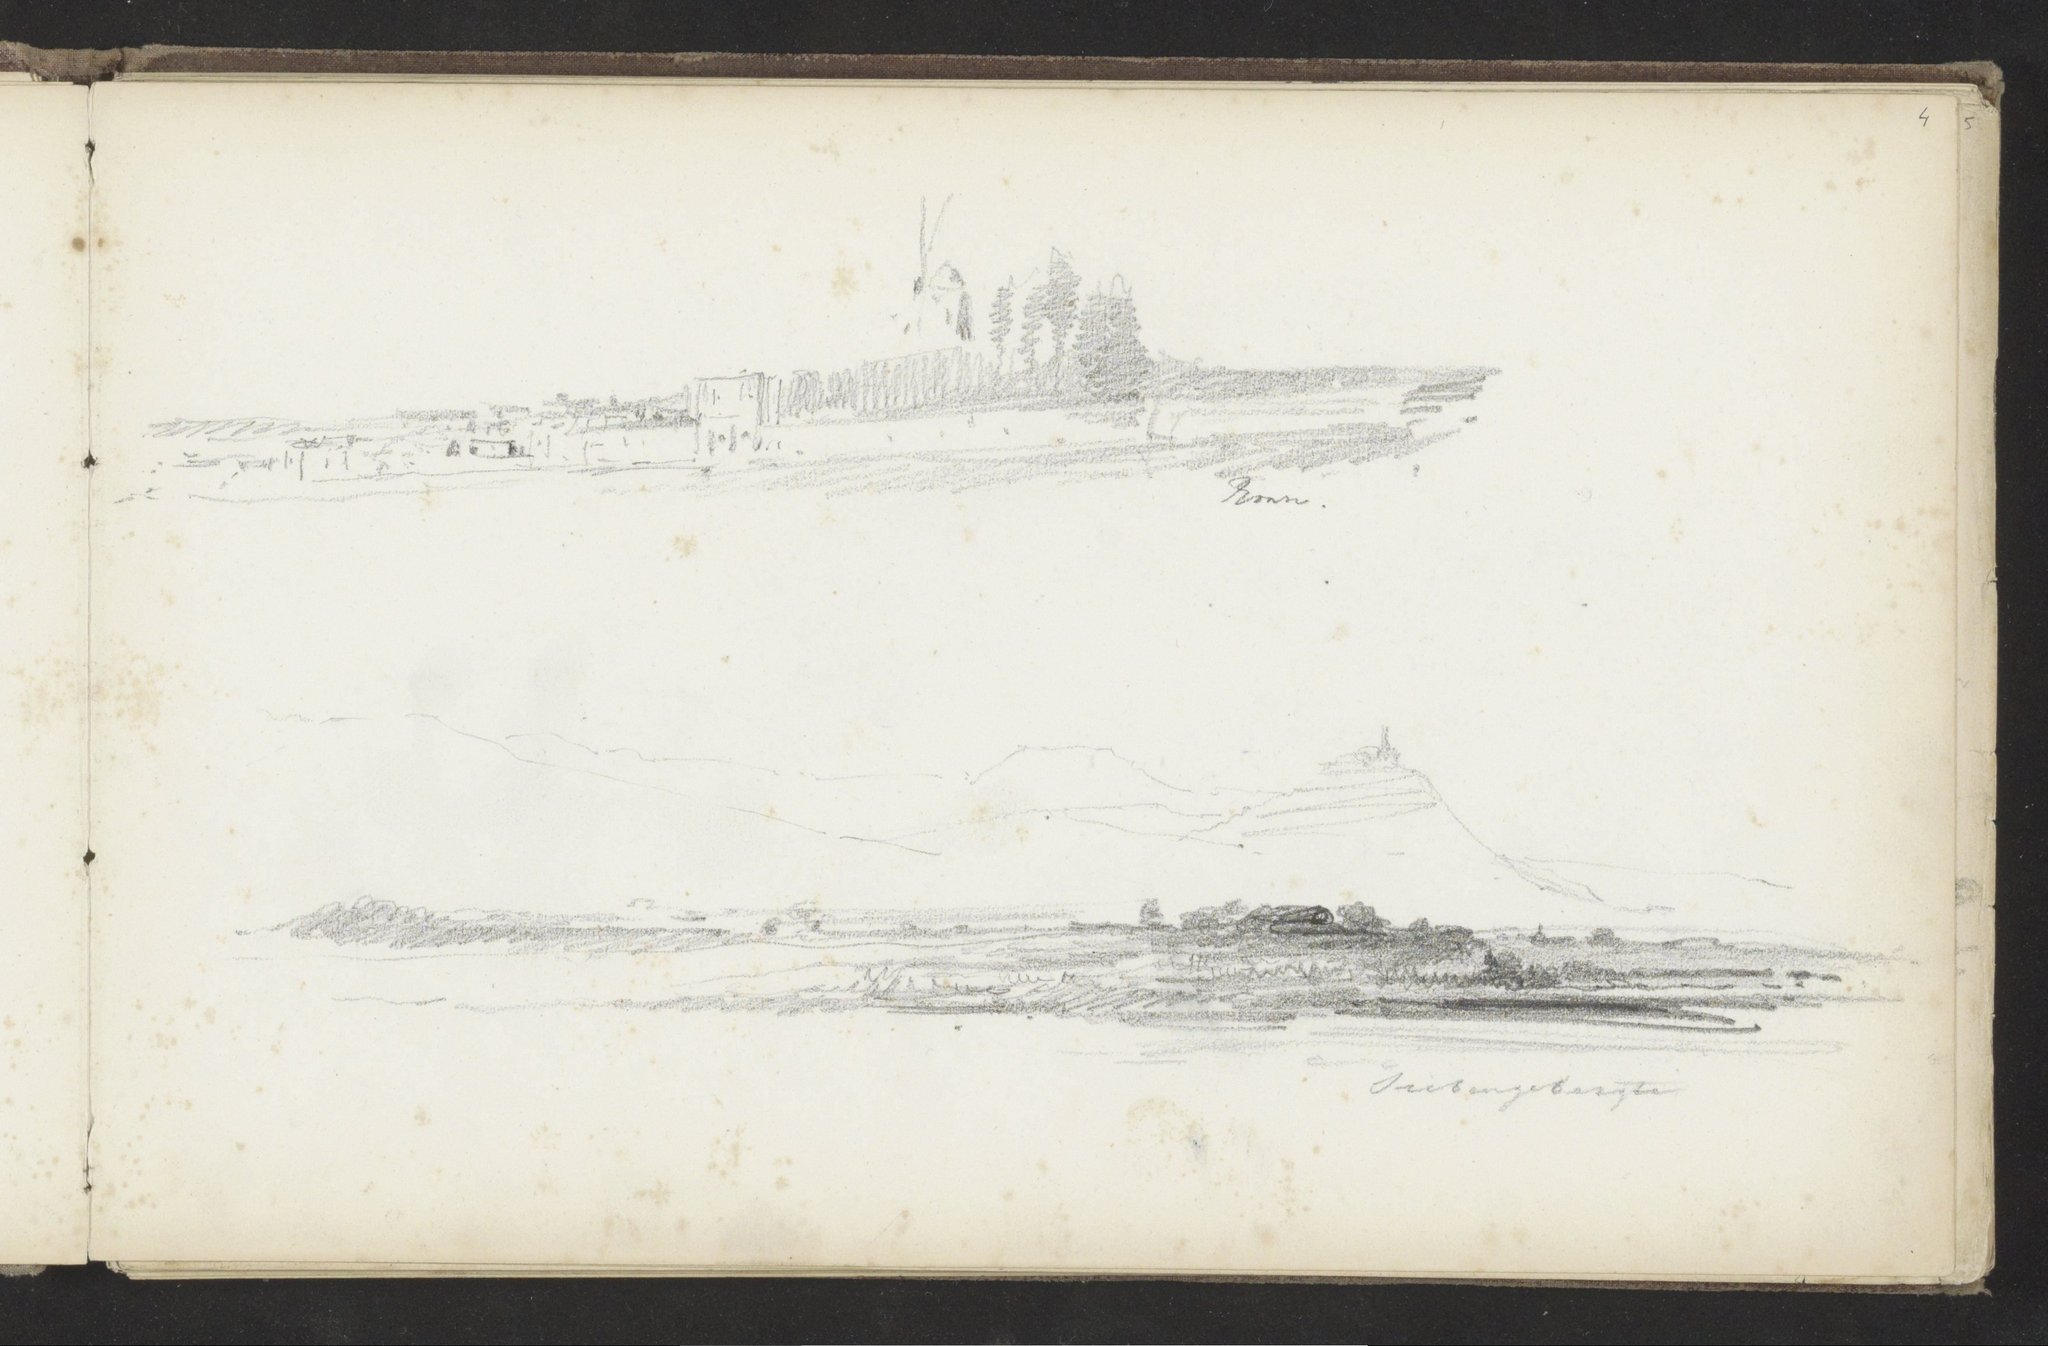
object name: sketchbook leaf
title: Gezicht op Bonn en het Siebengebirge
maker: maria vos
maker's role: draughtsman, painter, print maker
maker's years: 1824-1906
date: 1860-1865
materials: paper, pencil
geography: bonn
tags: city-view, and landscape with man-made constructions, mountains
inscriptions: annotation: ‘Bonn./ Siebengebergte’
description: Blad 4 recto uit een schetsboek met 55 bladen.